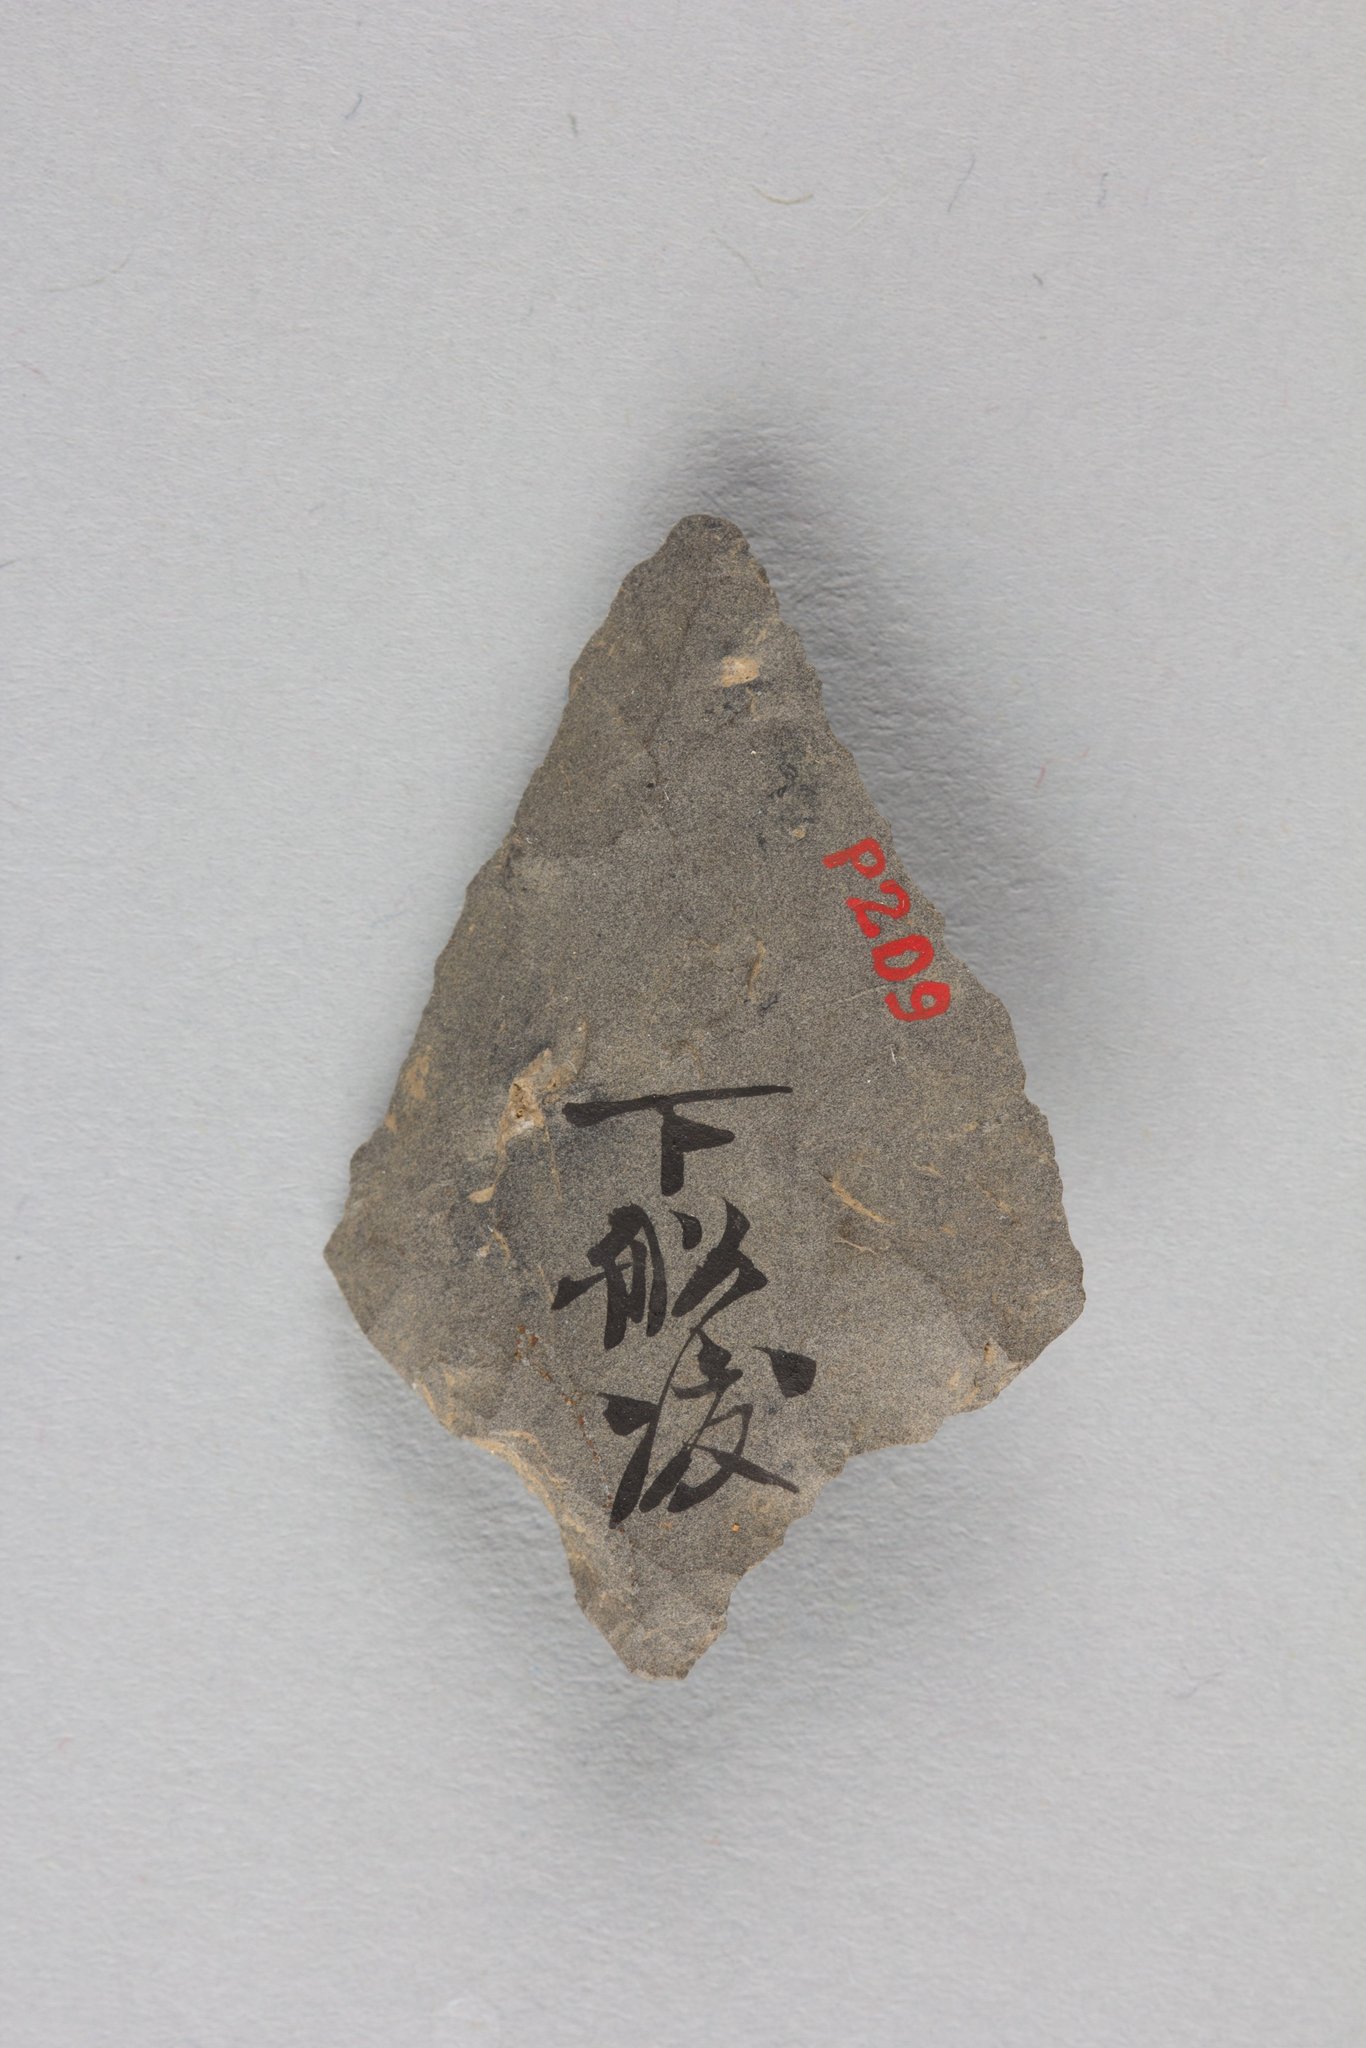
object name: arrowhead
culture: japanese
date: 1500-1000 BCE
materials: stone